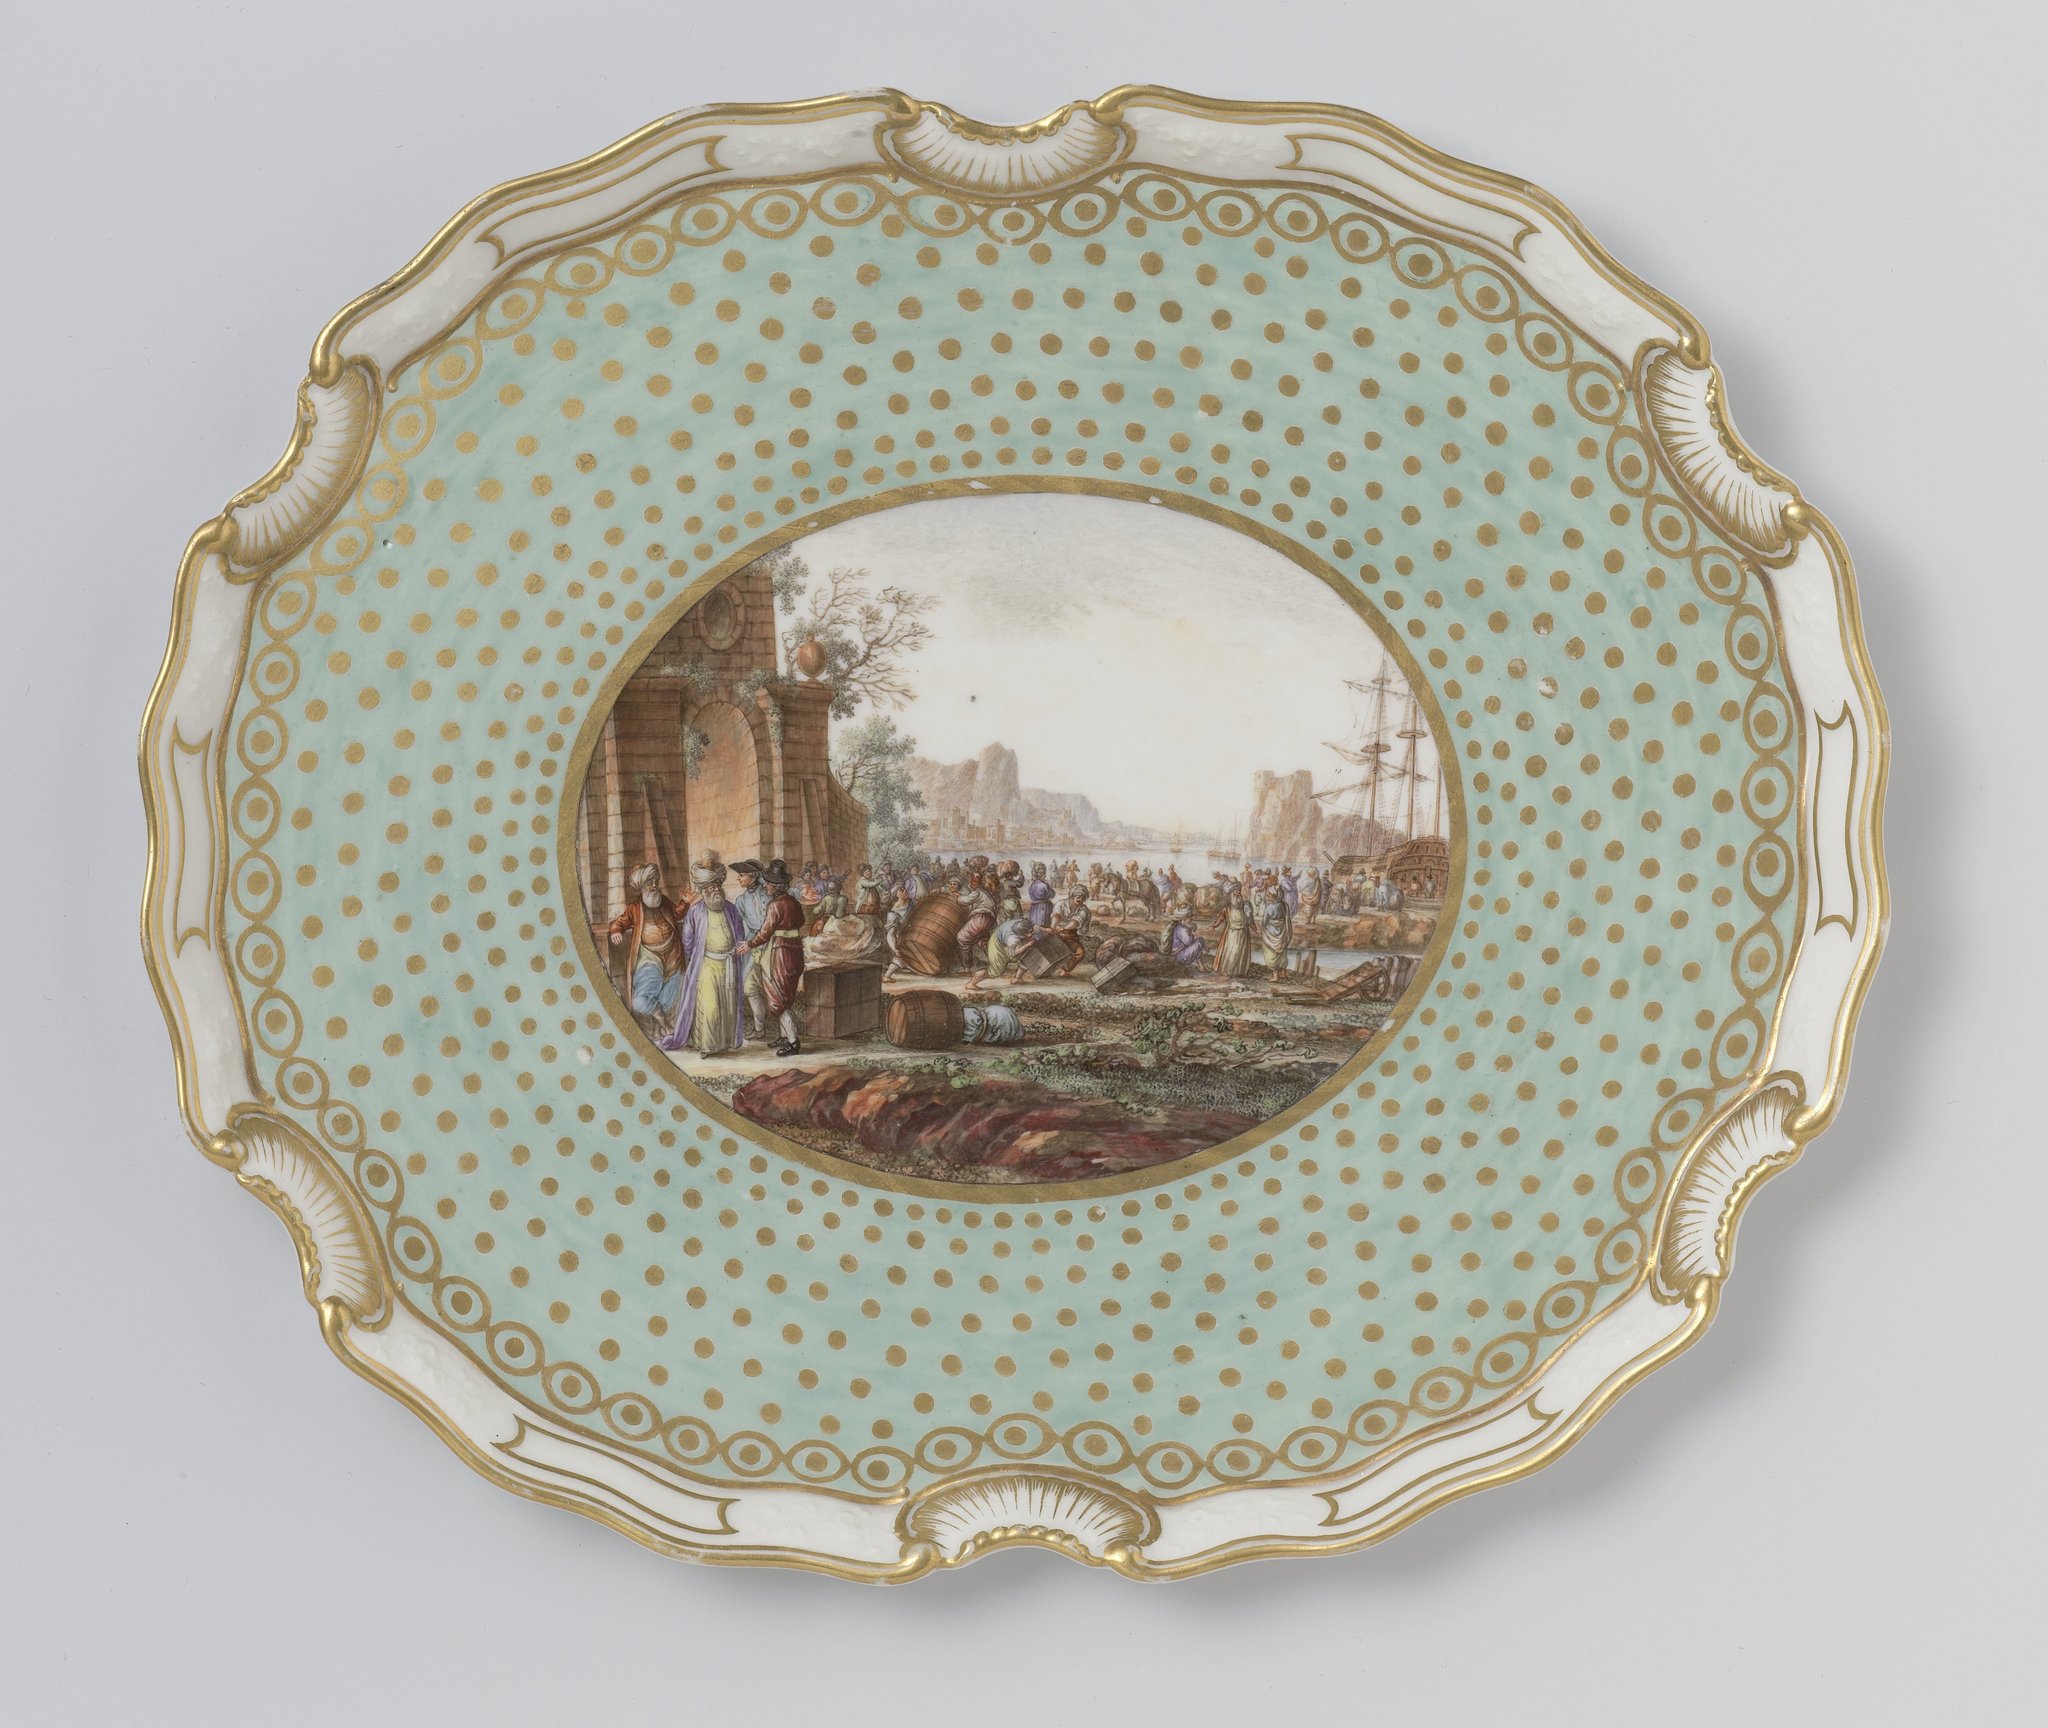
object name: blad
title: Tea service for two people (tête-à-tête)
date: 1782-1784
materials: porcelain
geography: loosdrecht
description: Manufactuur Oud-Loosdrecht sugar bowl: Manufactuur Oud-Loosdrecht or Porceleinfabriek aan den Amstel Loosdrecht and Ouder-Amstel, c. 1782–1784 hard-paste porcelain